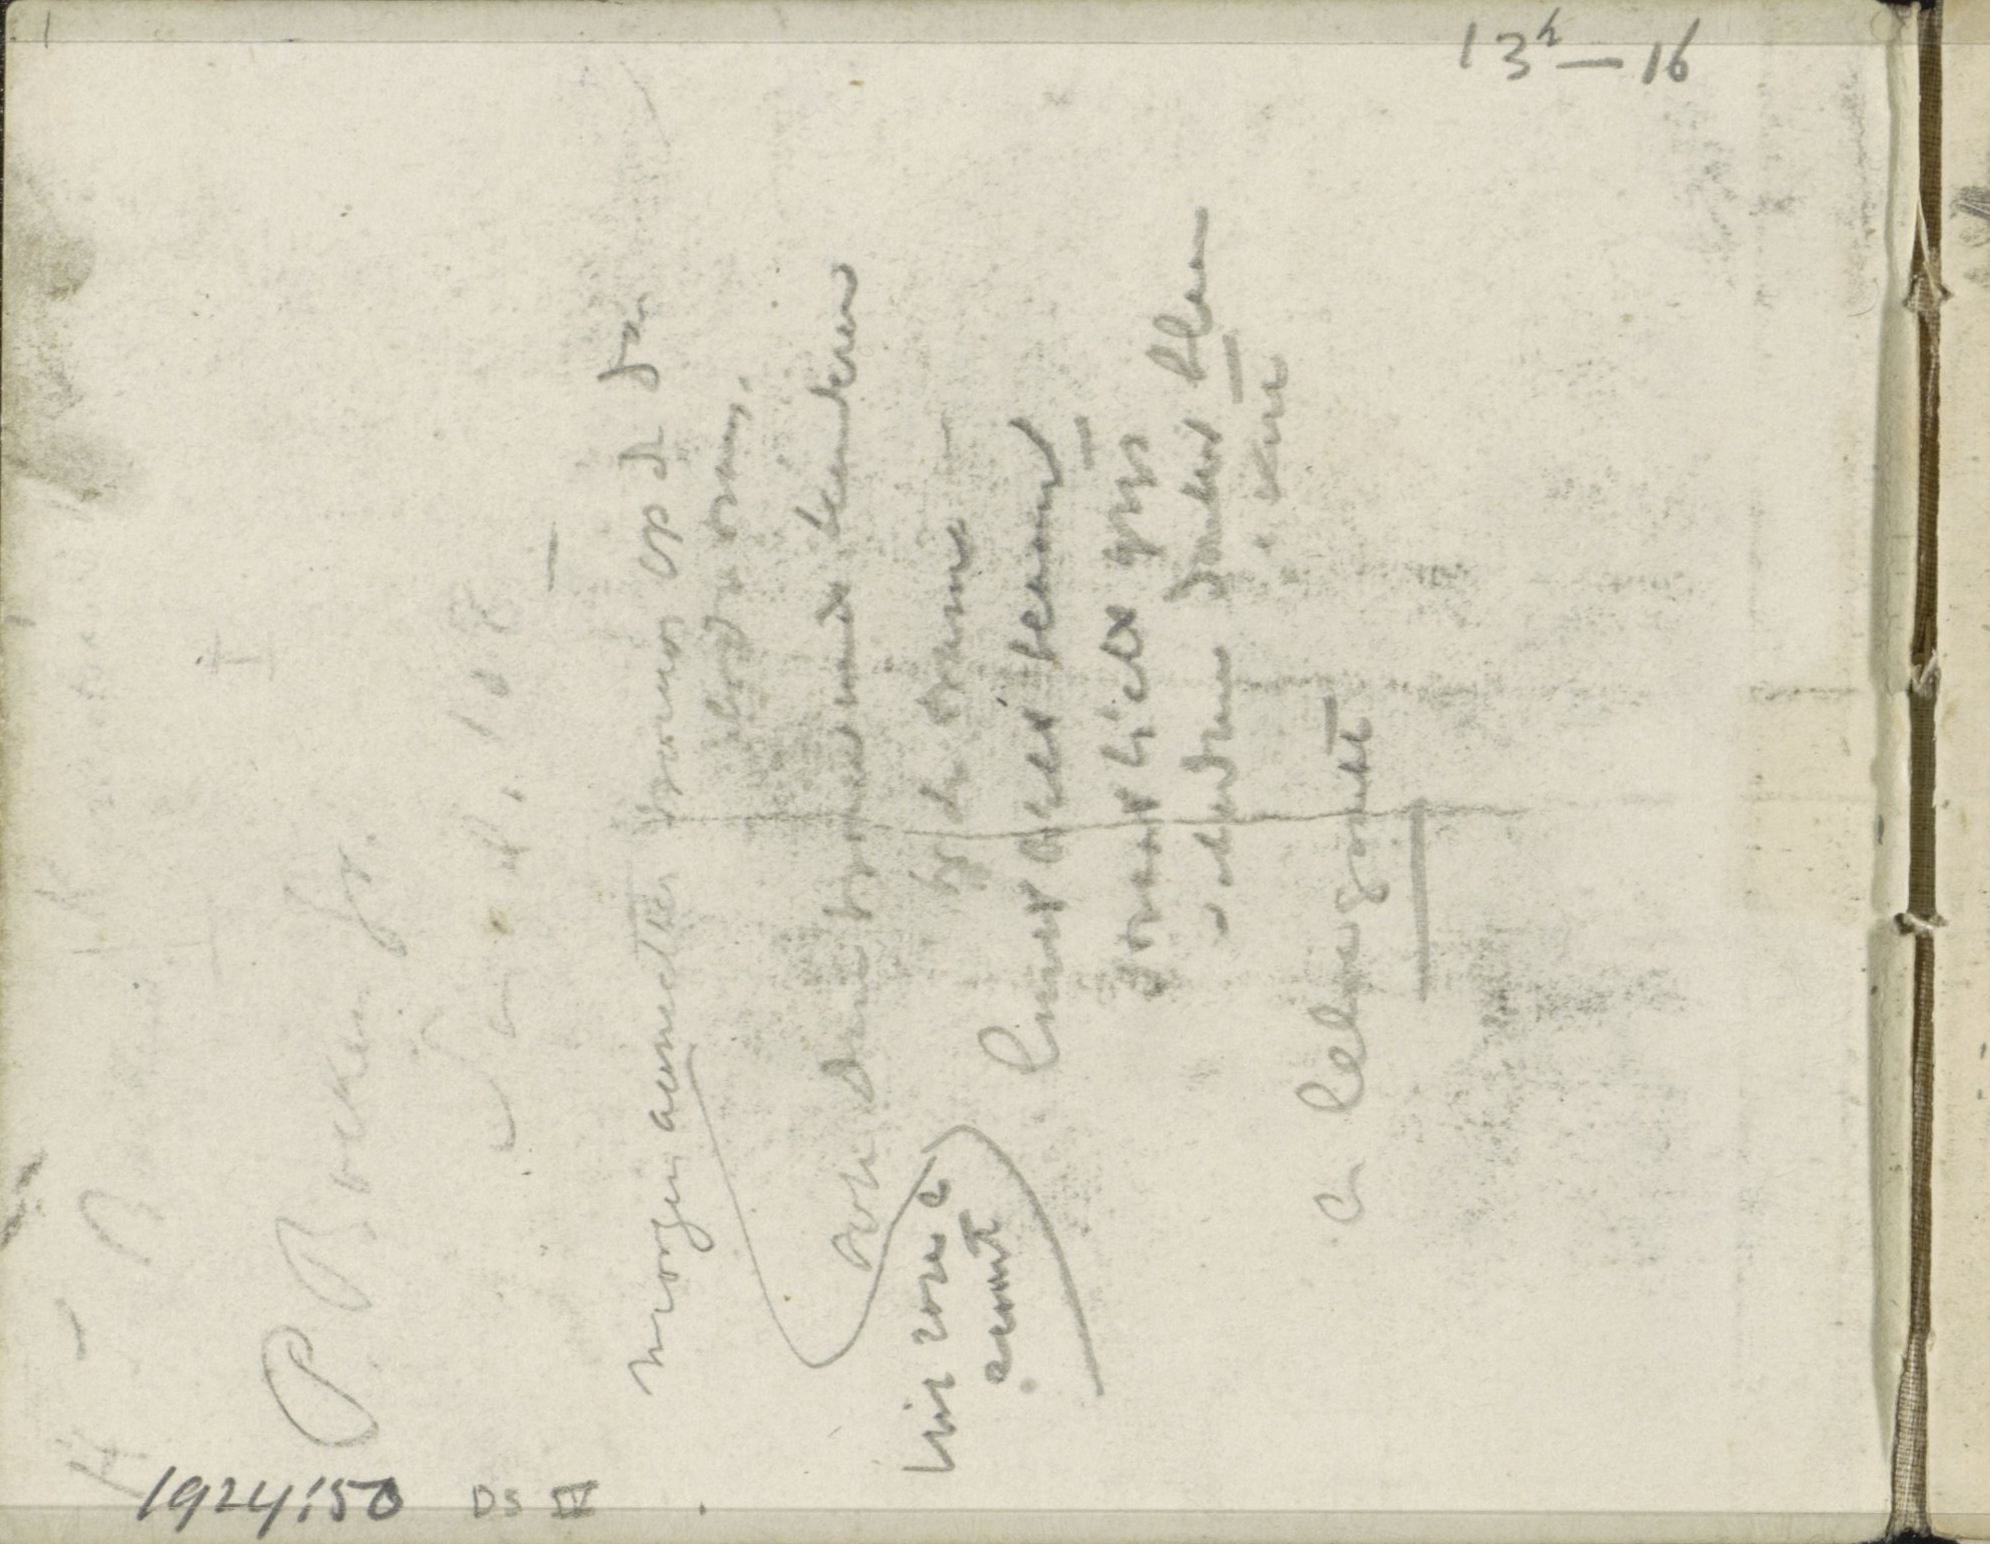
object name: endleaf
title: Annotaties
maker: george hendrik breitner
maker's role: draughtsman, painter, print maker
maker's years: 1857-1923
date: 1893-1912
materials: paper, pencil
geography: amsterdam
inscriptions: annotation: ‘P. Boeken gr./ Singel 102/ [...]/ en Leliegracht’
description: Pagina 1, voorste schutblad, uit een schetsboek met 32 bladen.